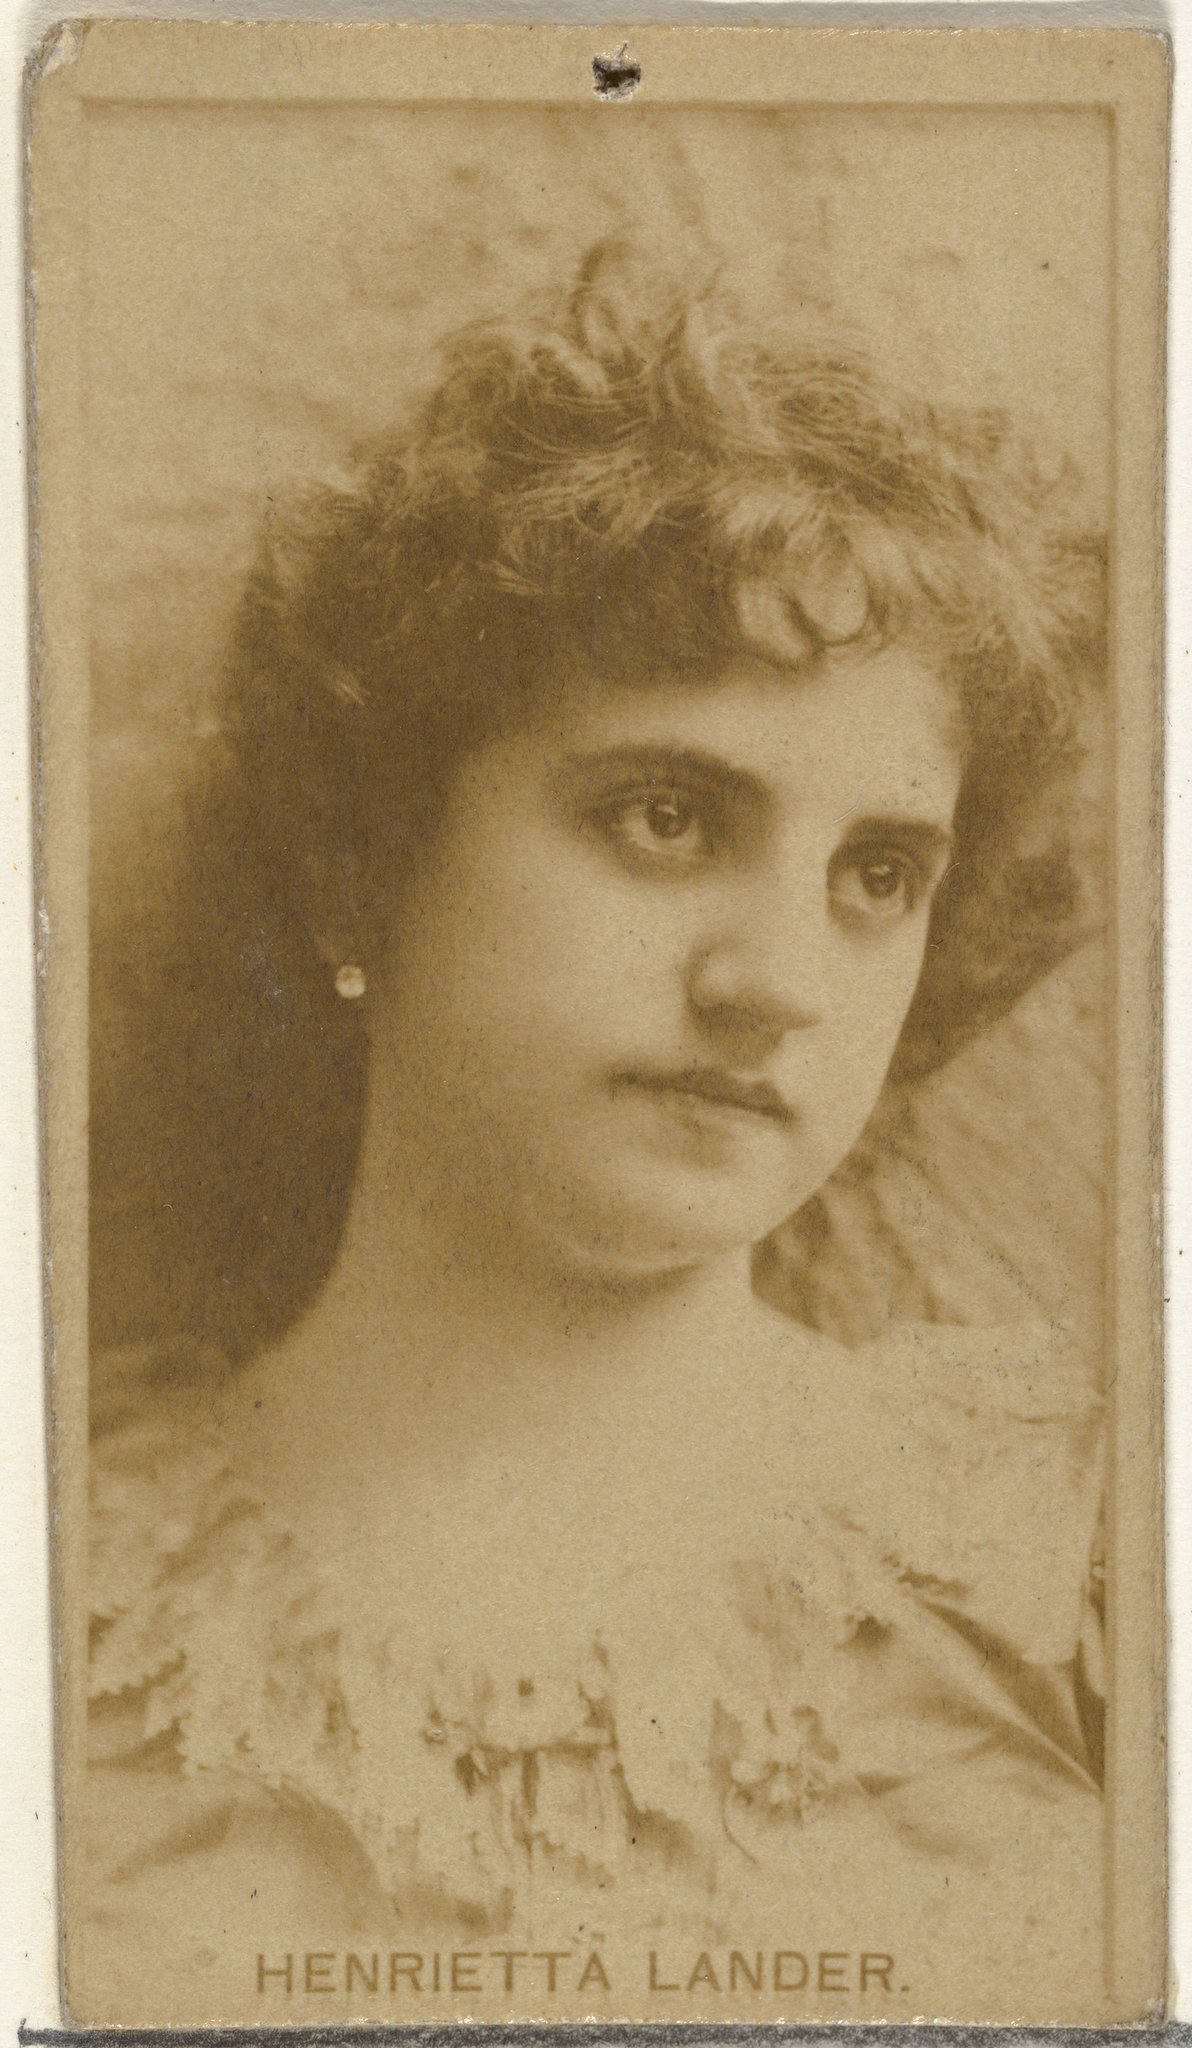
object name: photograph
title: Henrietta Lander, from the Actors and Actresses series (N145-8) issued by Duke Sons & Co. to promote Duke Cigarettes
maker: w. duke, sons & co.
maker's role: publisher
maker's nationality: american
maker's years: 1870-1920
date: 1891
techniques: albumen silver print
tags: portraits,women,actresses